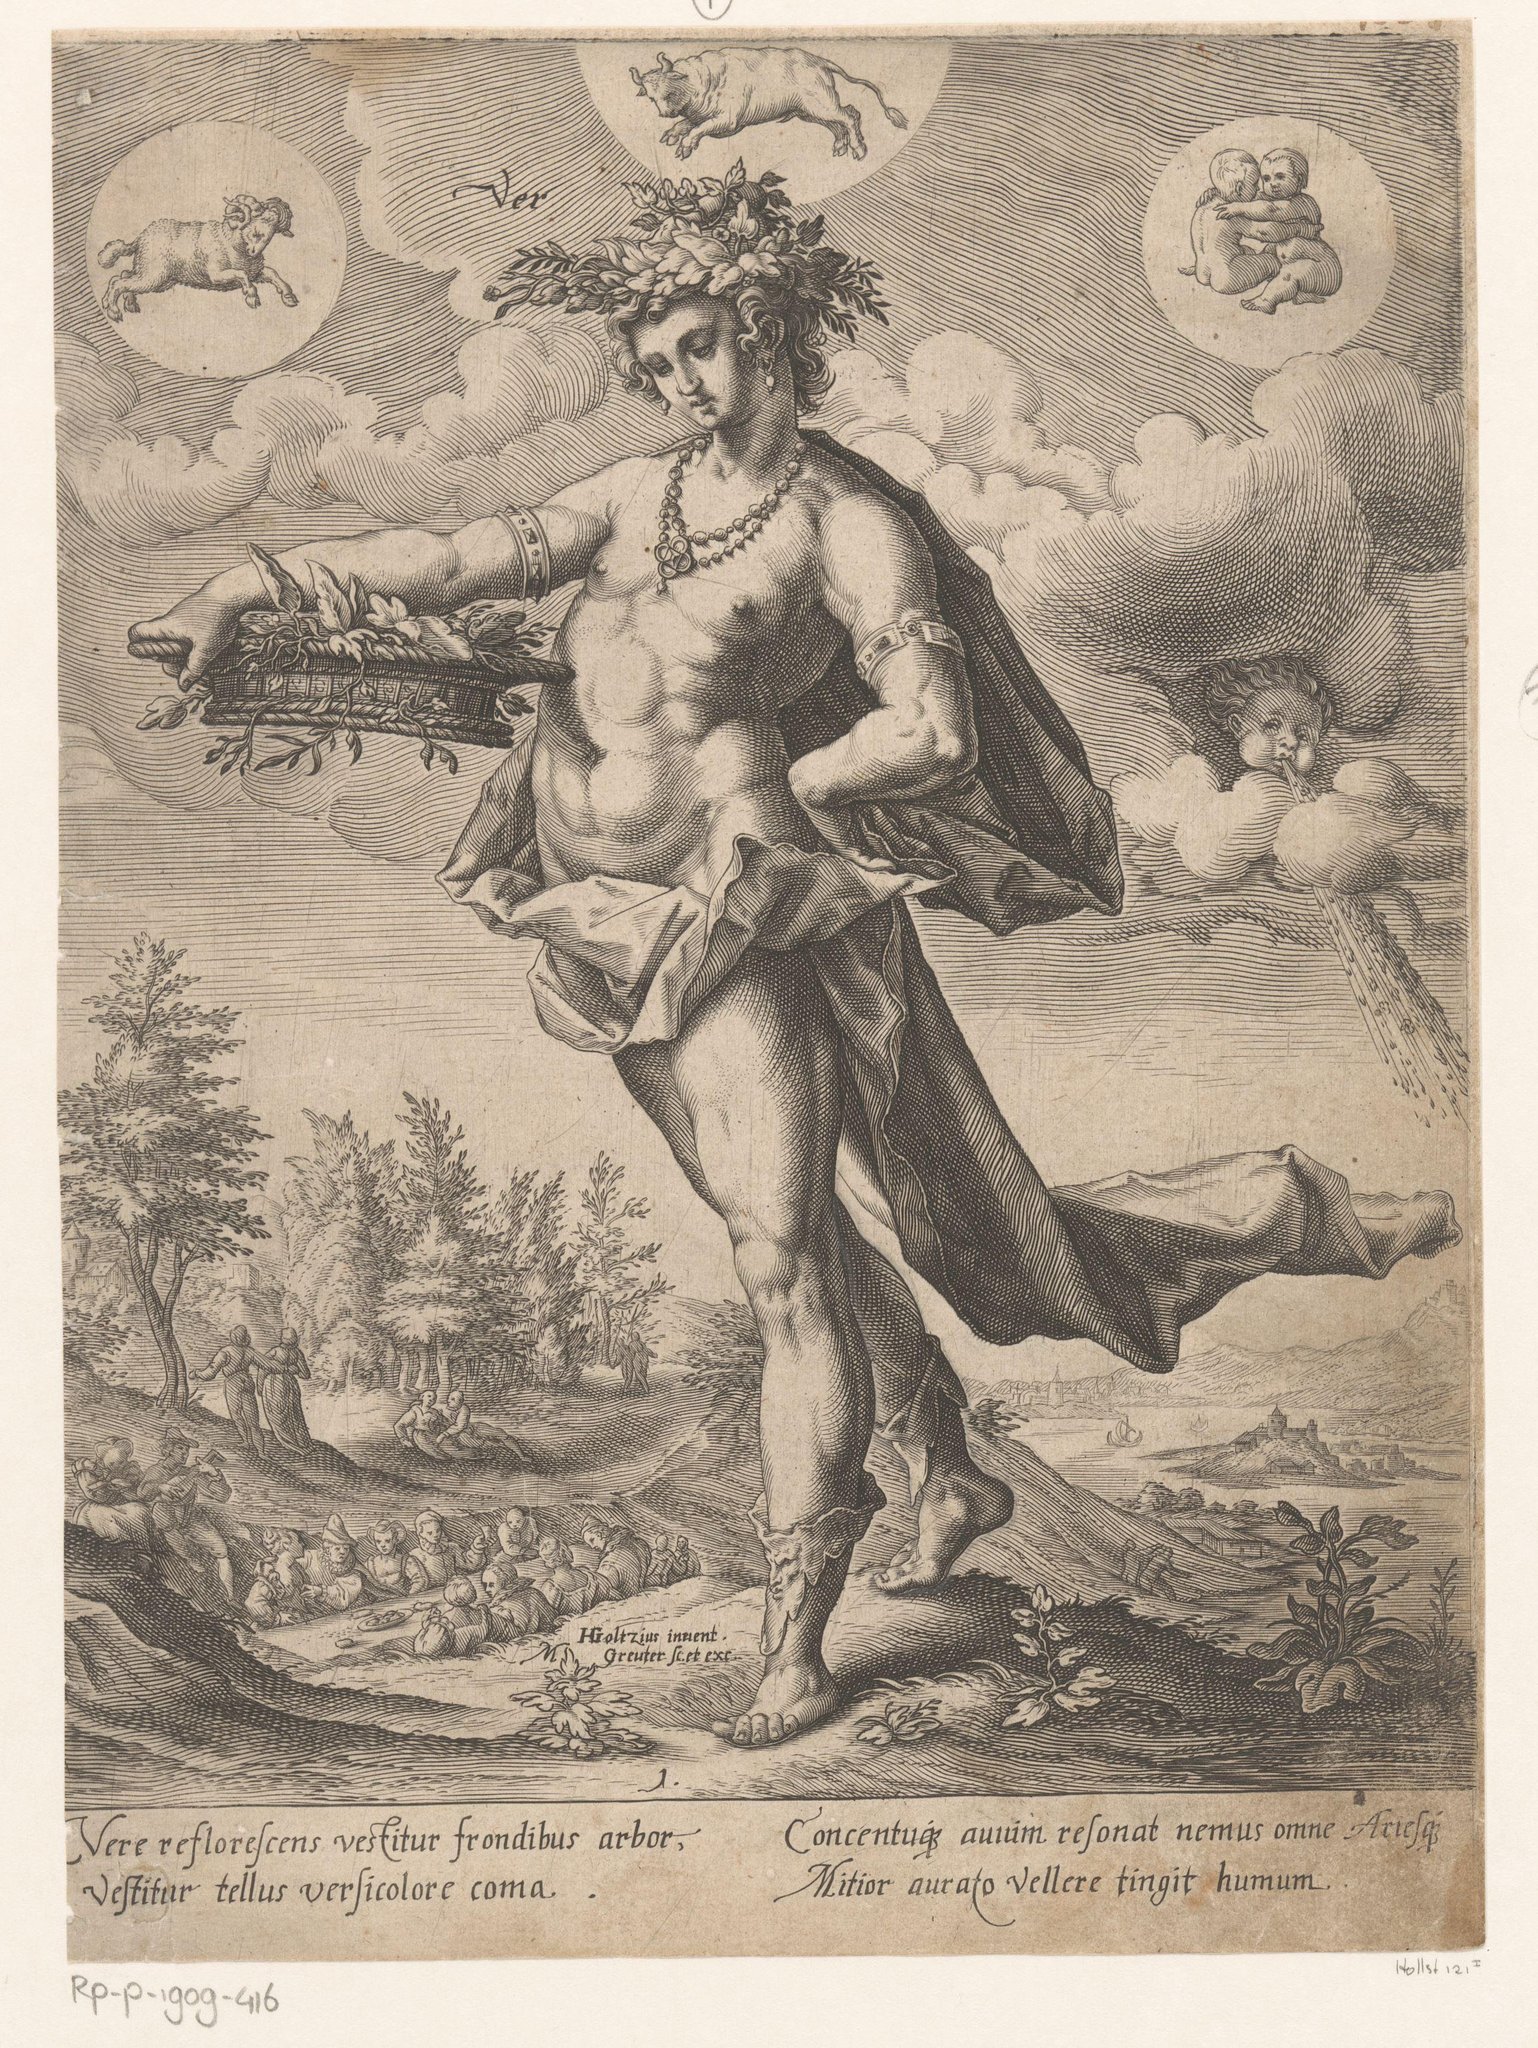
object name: print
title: De vier seizoenen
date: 1585-1638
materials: paper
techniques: engraving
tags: wind as a human face, blowing with rounded cheeks, spring, 'ver'; 'primavera' (ripa), festivities connected with seasonal activities, zodiacal signs of the spring season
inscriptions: collector's mark: Lugt 2228